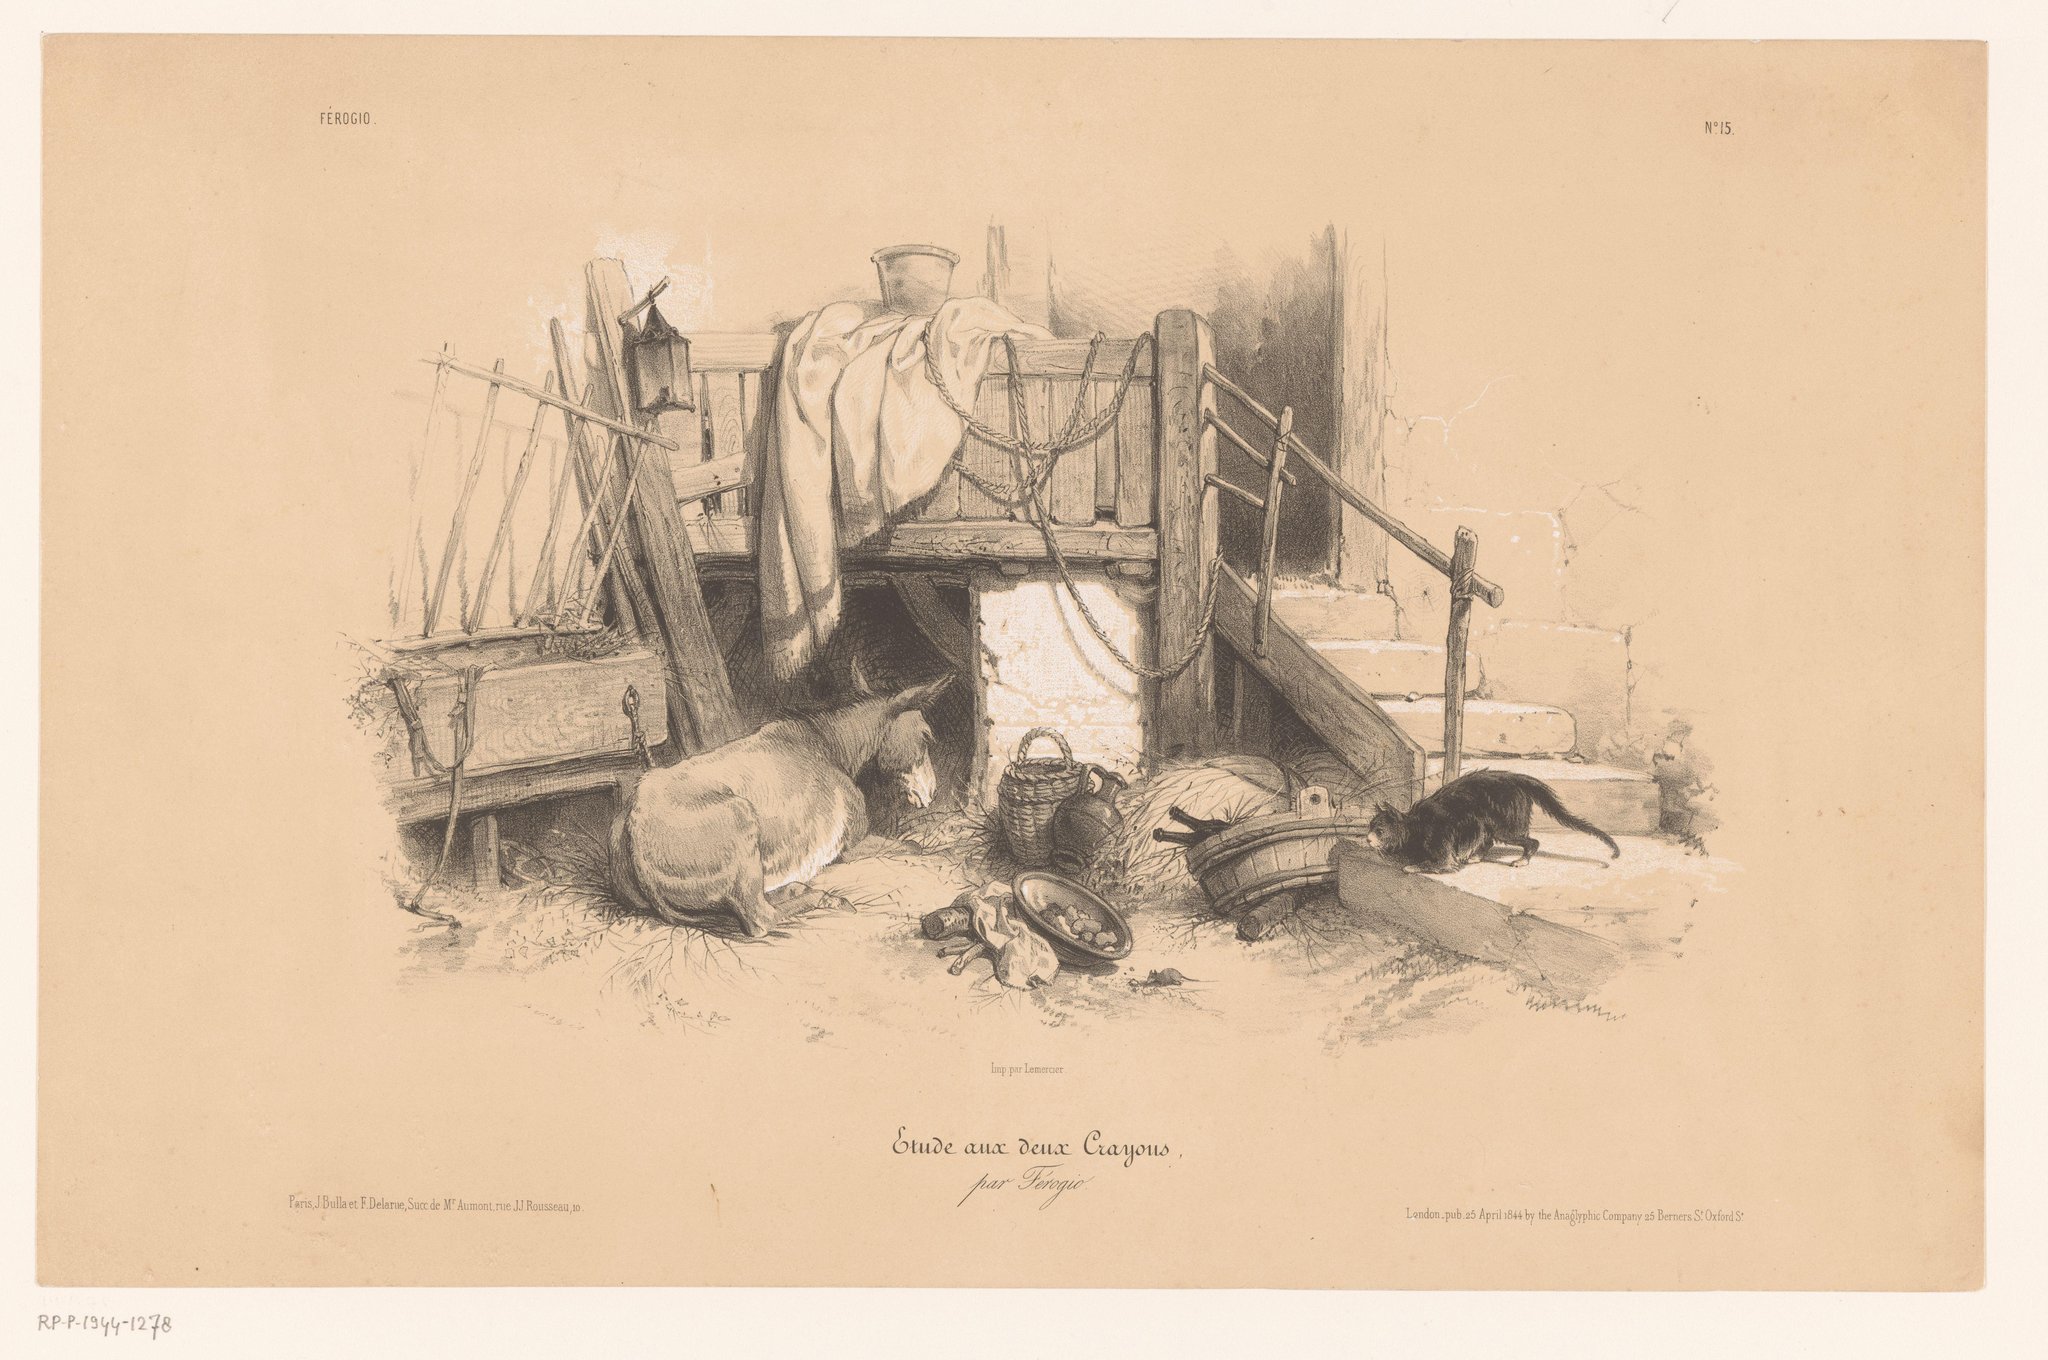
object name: print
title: Studies met twee soorten krijt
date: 1844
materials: paper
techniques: lithography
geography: london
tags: ass, donkey, stall, stable, cat and mouse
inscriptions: collector's mark: Lugt 2228a